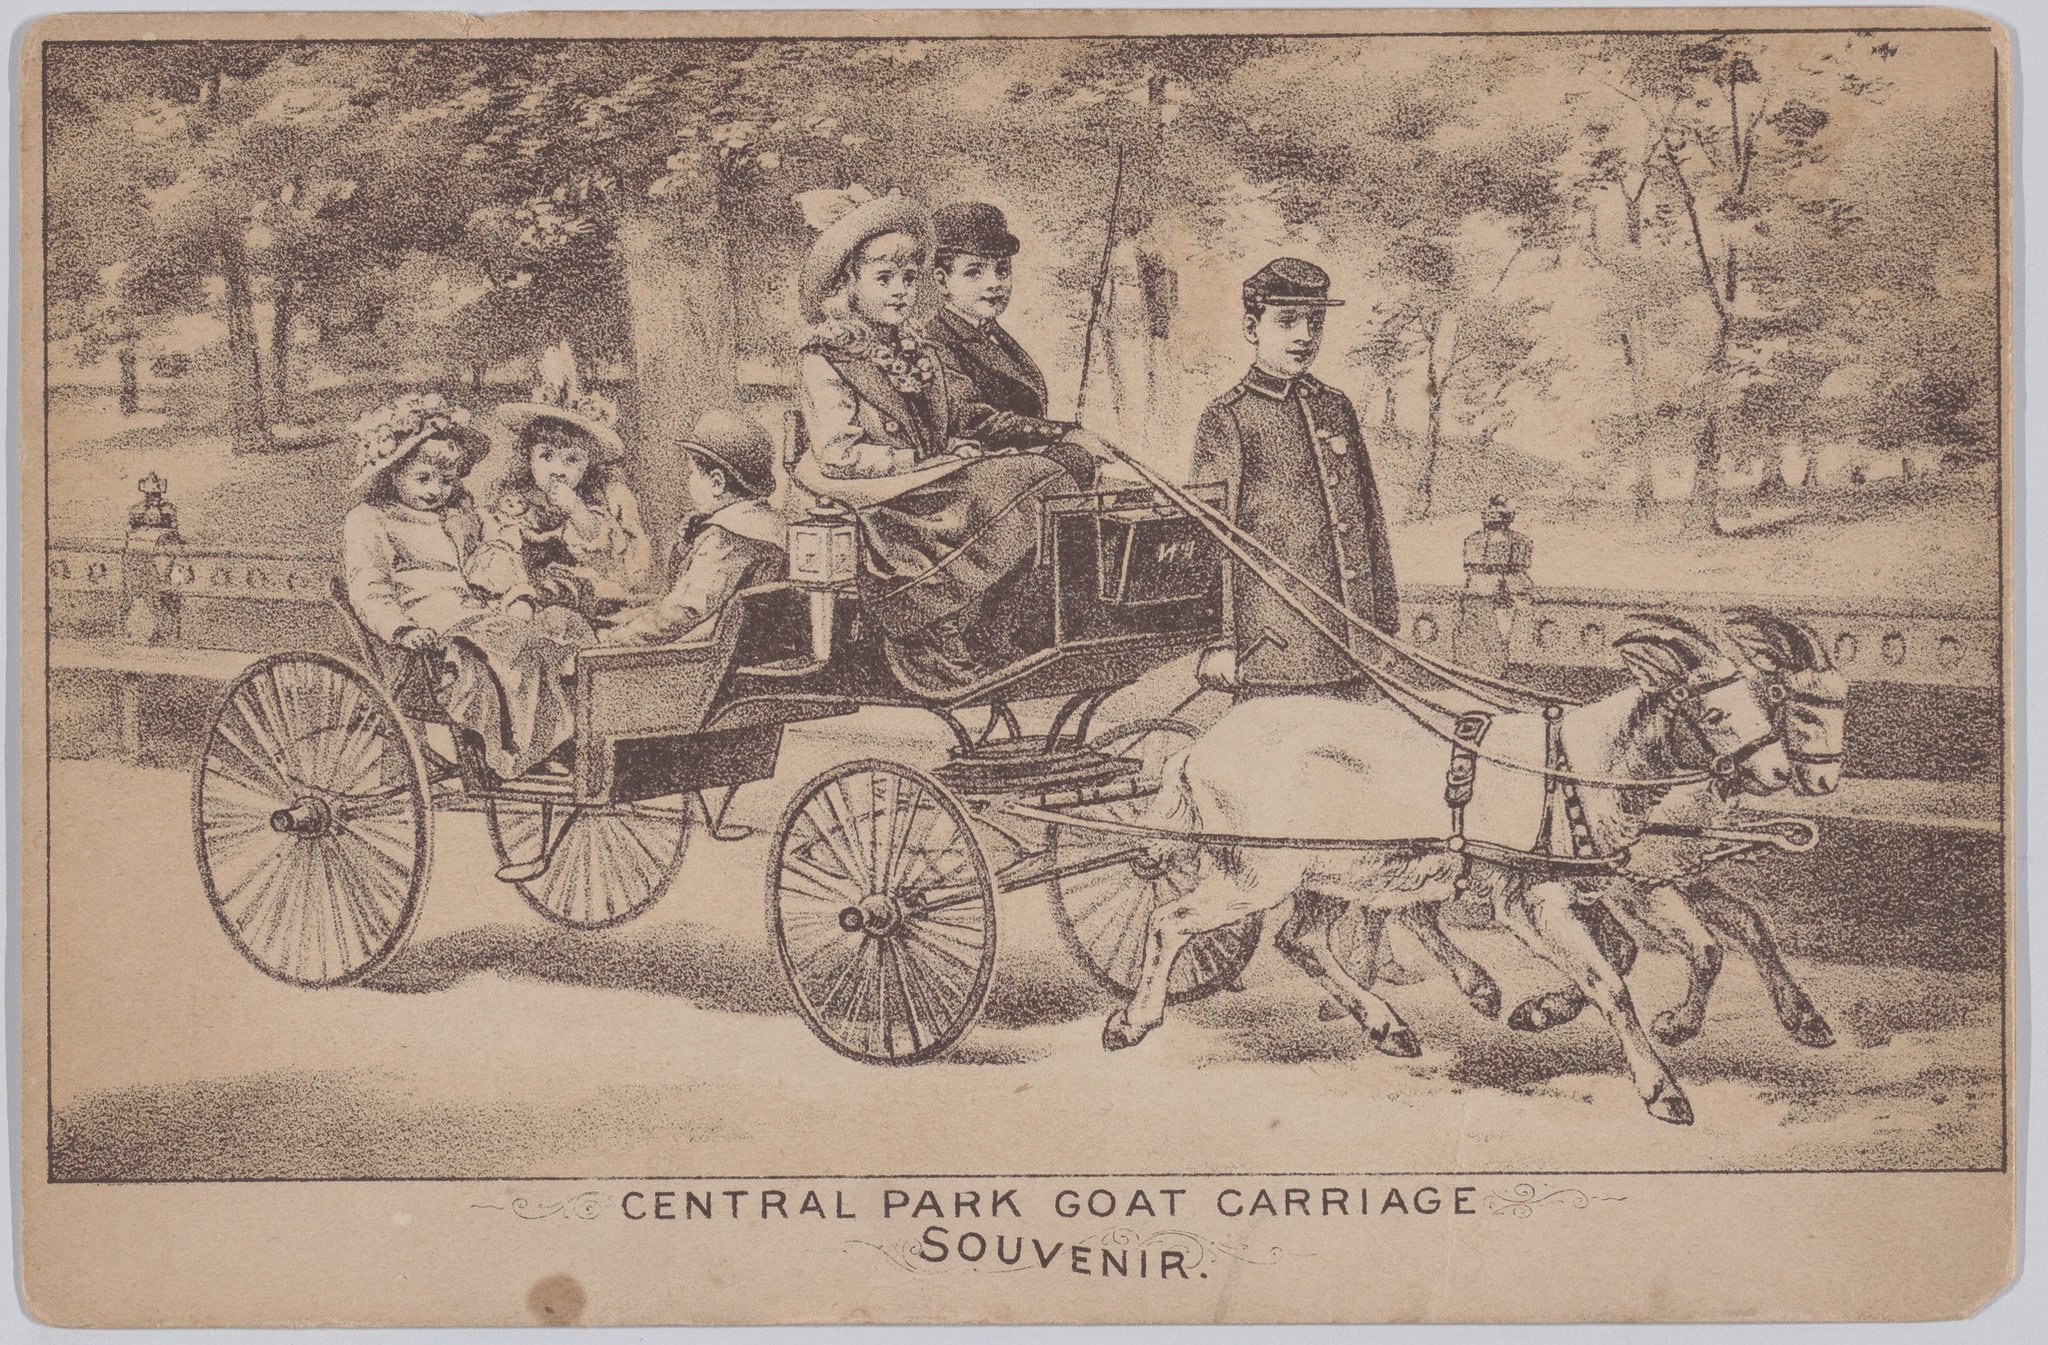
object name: print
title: Central Park Goat Carriage (Souvenir Postcard)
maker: anonymous, american, 19th century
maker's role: artist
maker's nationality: american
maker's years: 1800-1900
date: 1894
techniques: lithograph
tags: children,boys,girls,goats,carriages